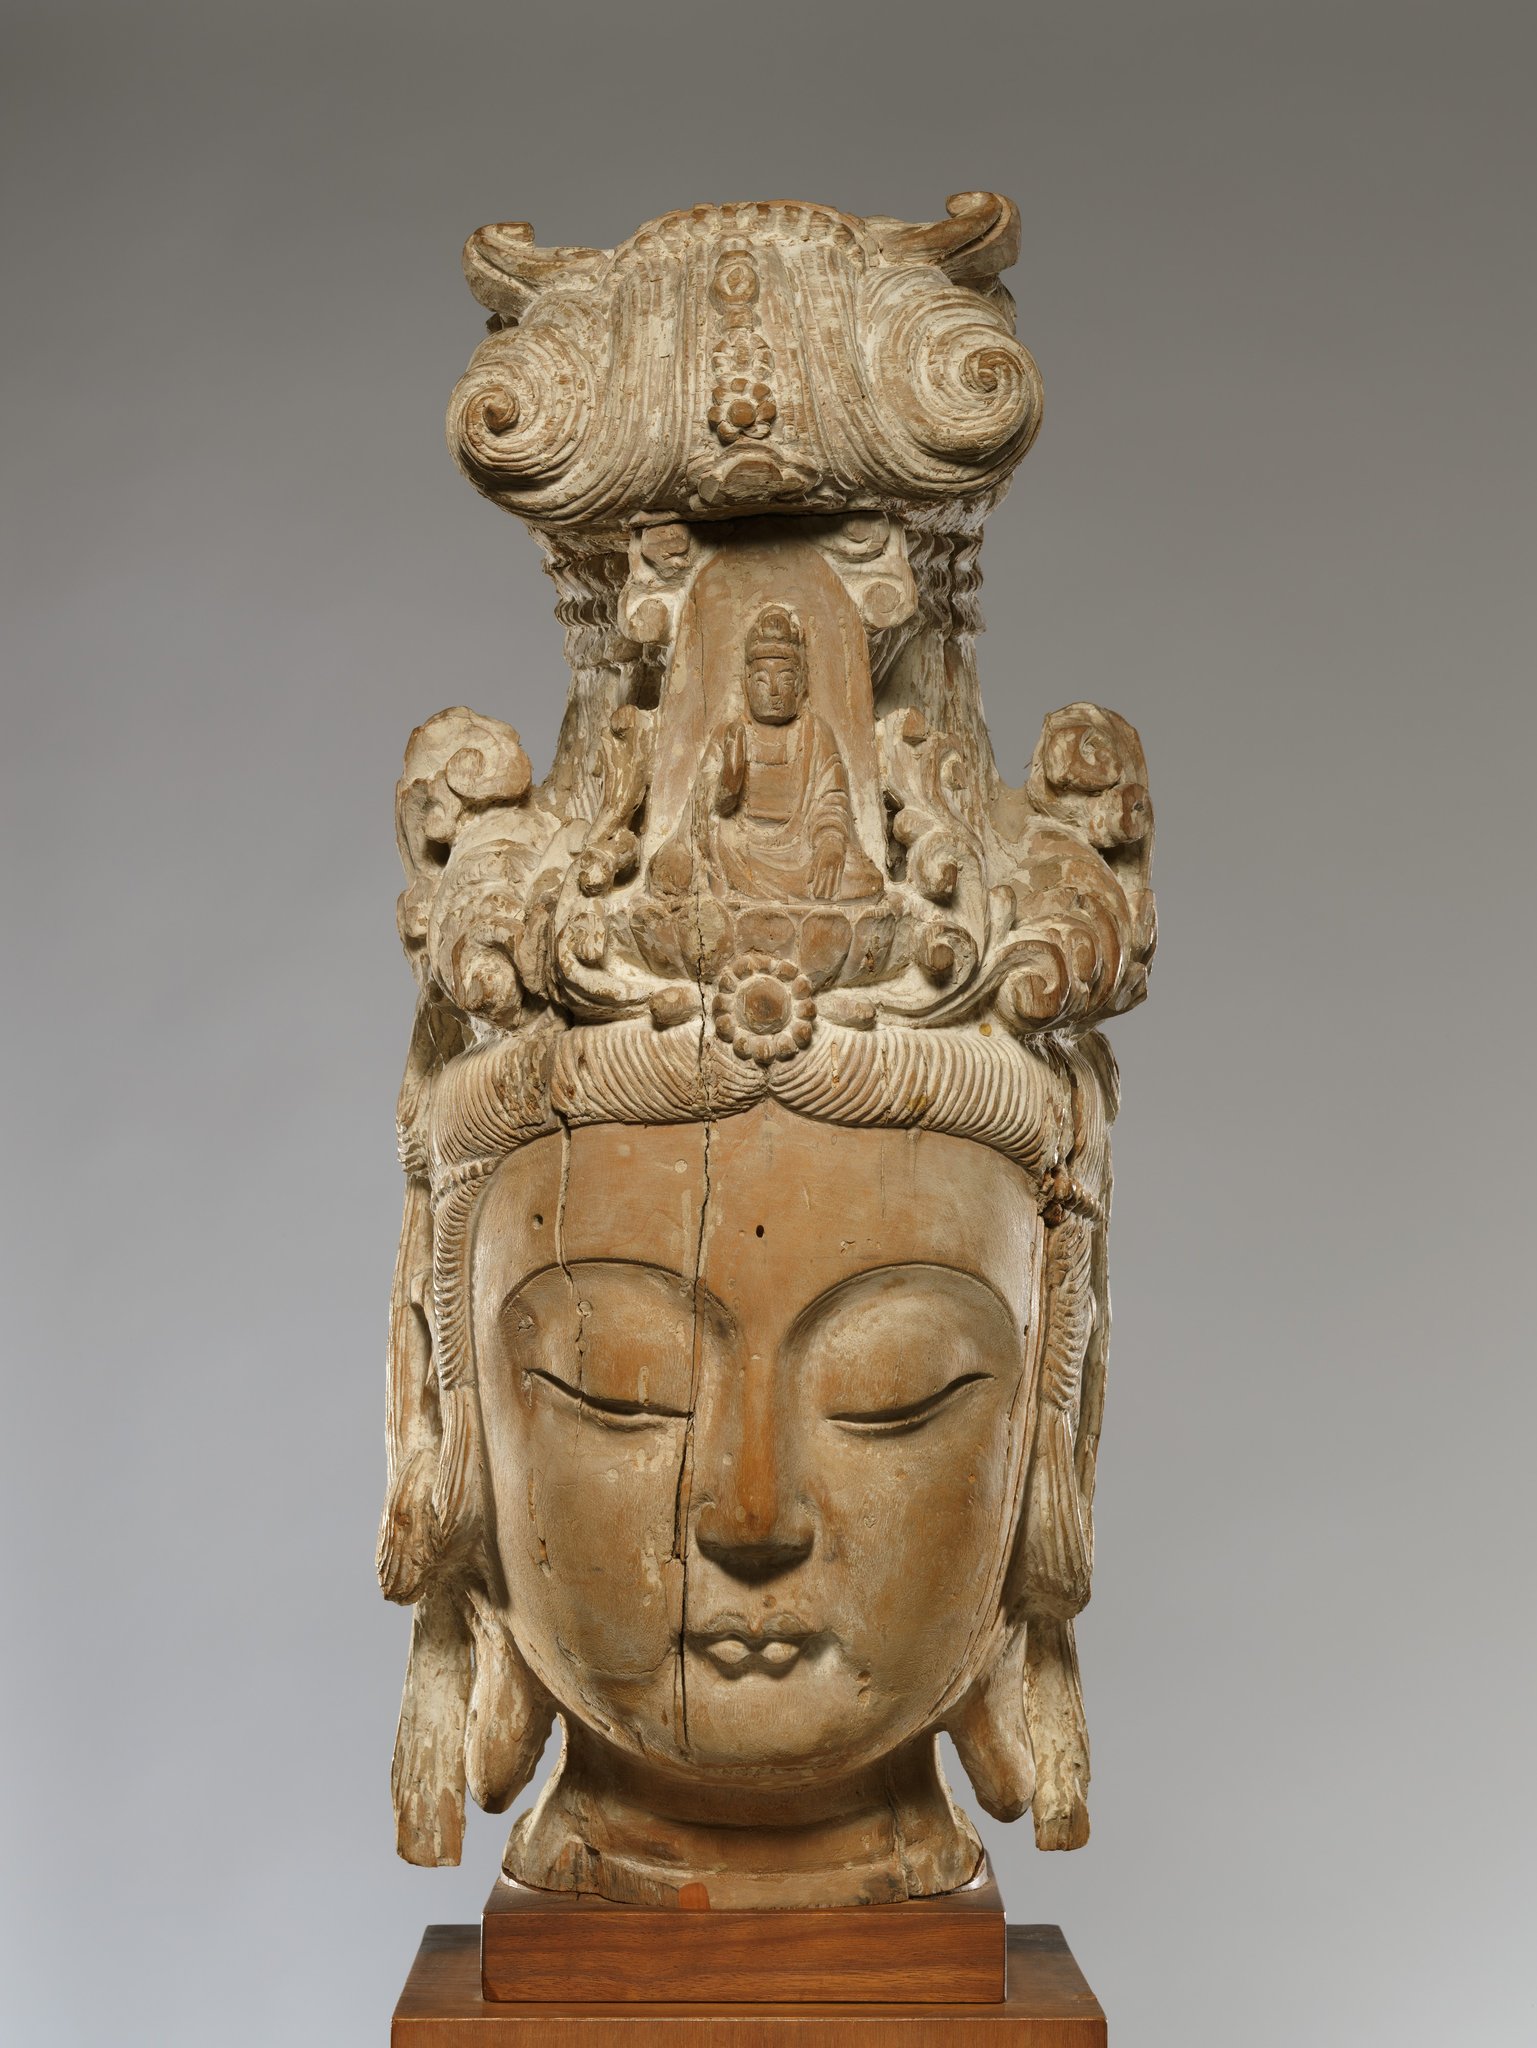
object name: head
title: Head of Guanyin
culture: chinese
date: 1368-1644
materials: wood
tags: bodhisattvas